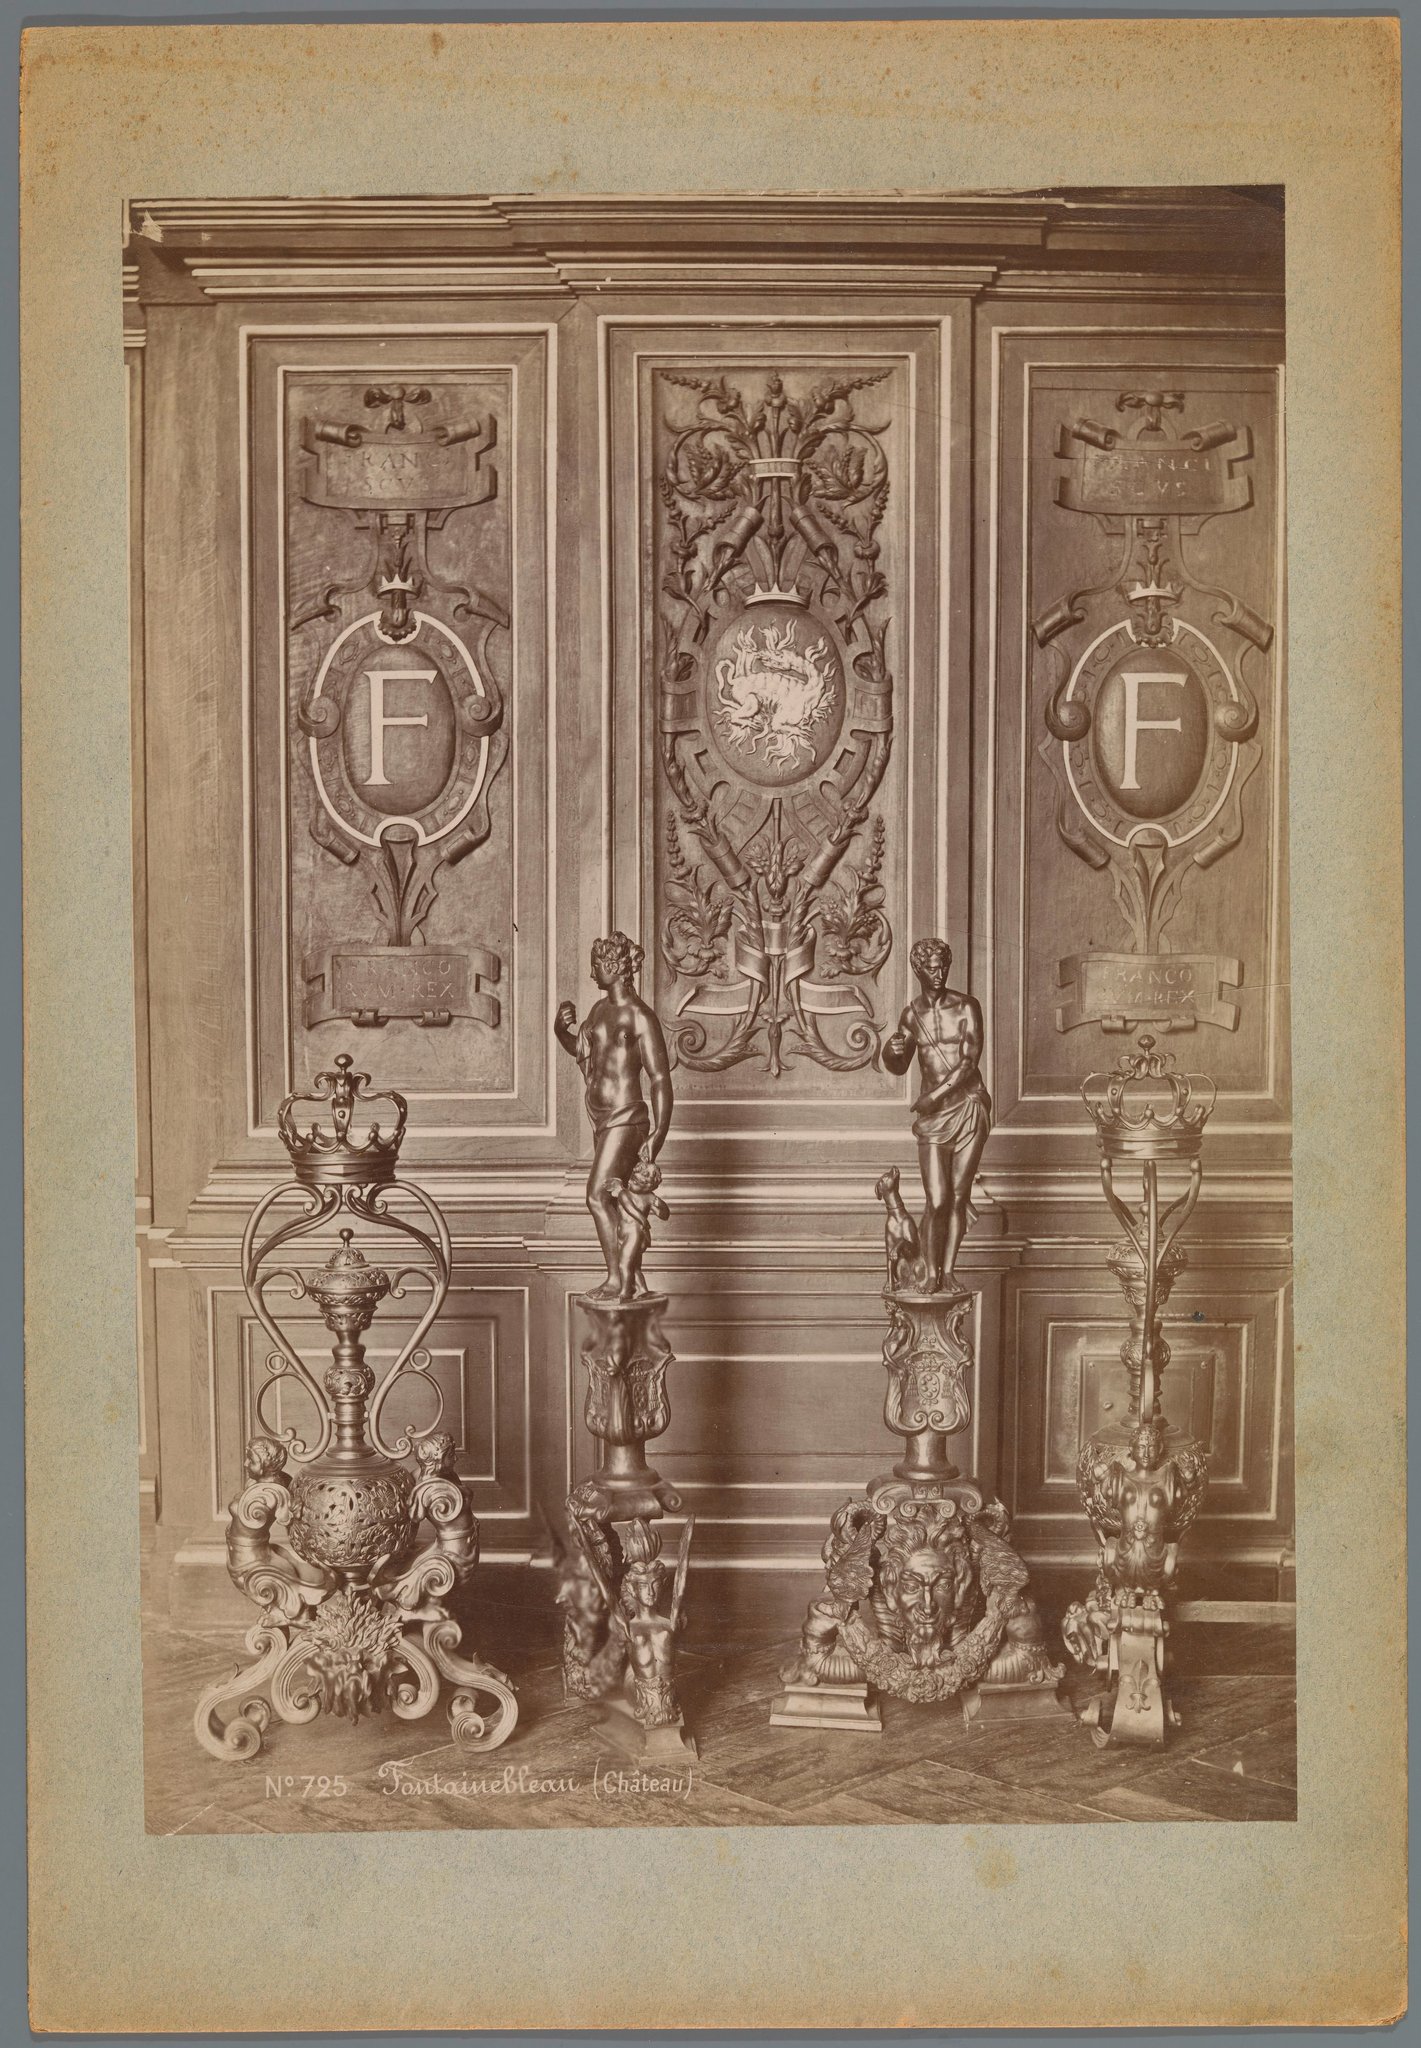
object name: photograph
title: Fontainebleau (Château)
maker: séraphin-médéric mieusement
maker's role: fotograaf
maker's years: 1840-1905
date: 1875-1900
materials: cardboard, photographic support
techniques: albumen print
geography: fontainebleau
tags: palace, sculpture, interior ~ representation of a building, sculpture (+ relief ~ sculpture)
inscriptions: name: ‘MIEUSEMENT PHOTOGRAPHE’, collector's mark: Lugt 3937, name: ‘KUNSTBOEKHANDEL J. A. G. DE LEUR PHOTOGRAAF - UITGEVER HUIGENSPARK, 40b. DEN HAAG.’, number: ‘No. 725’, inscription: ‘MONUMENTS HISTORIQUES’